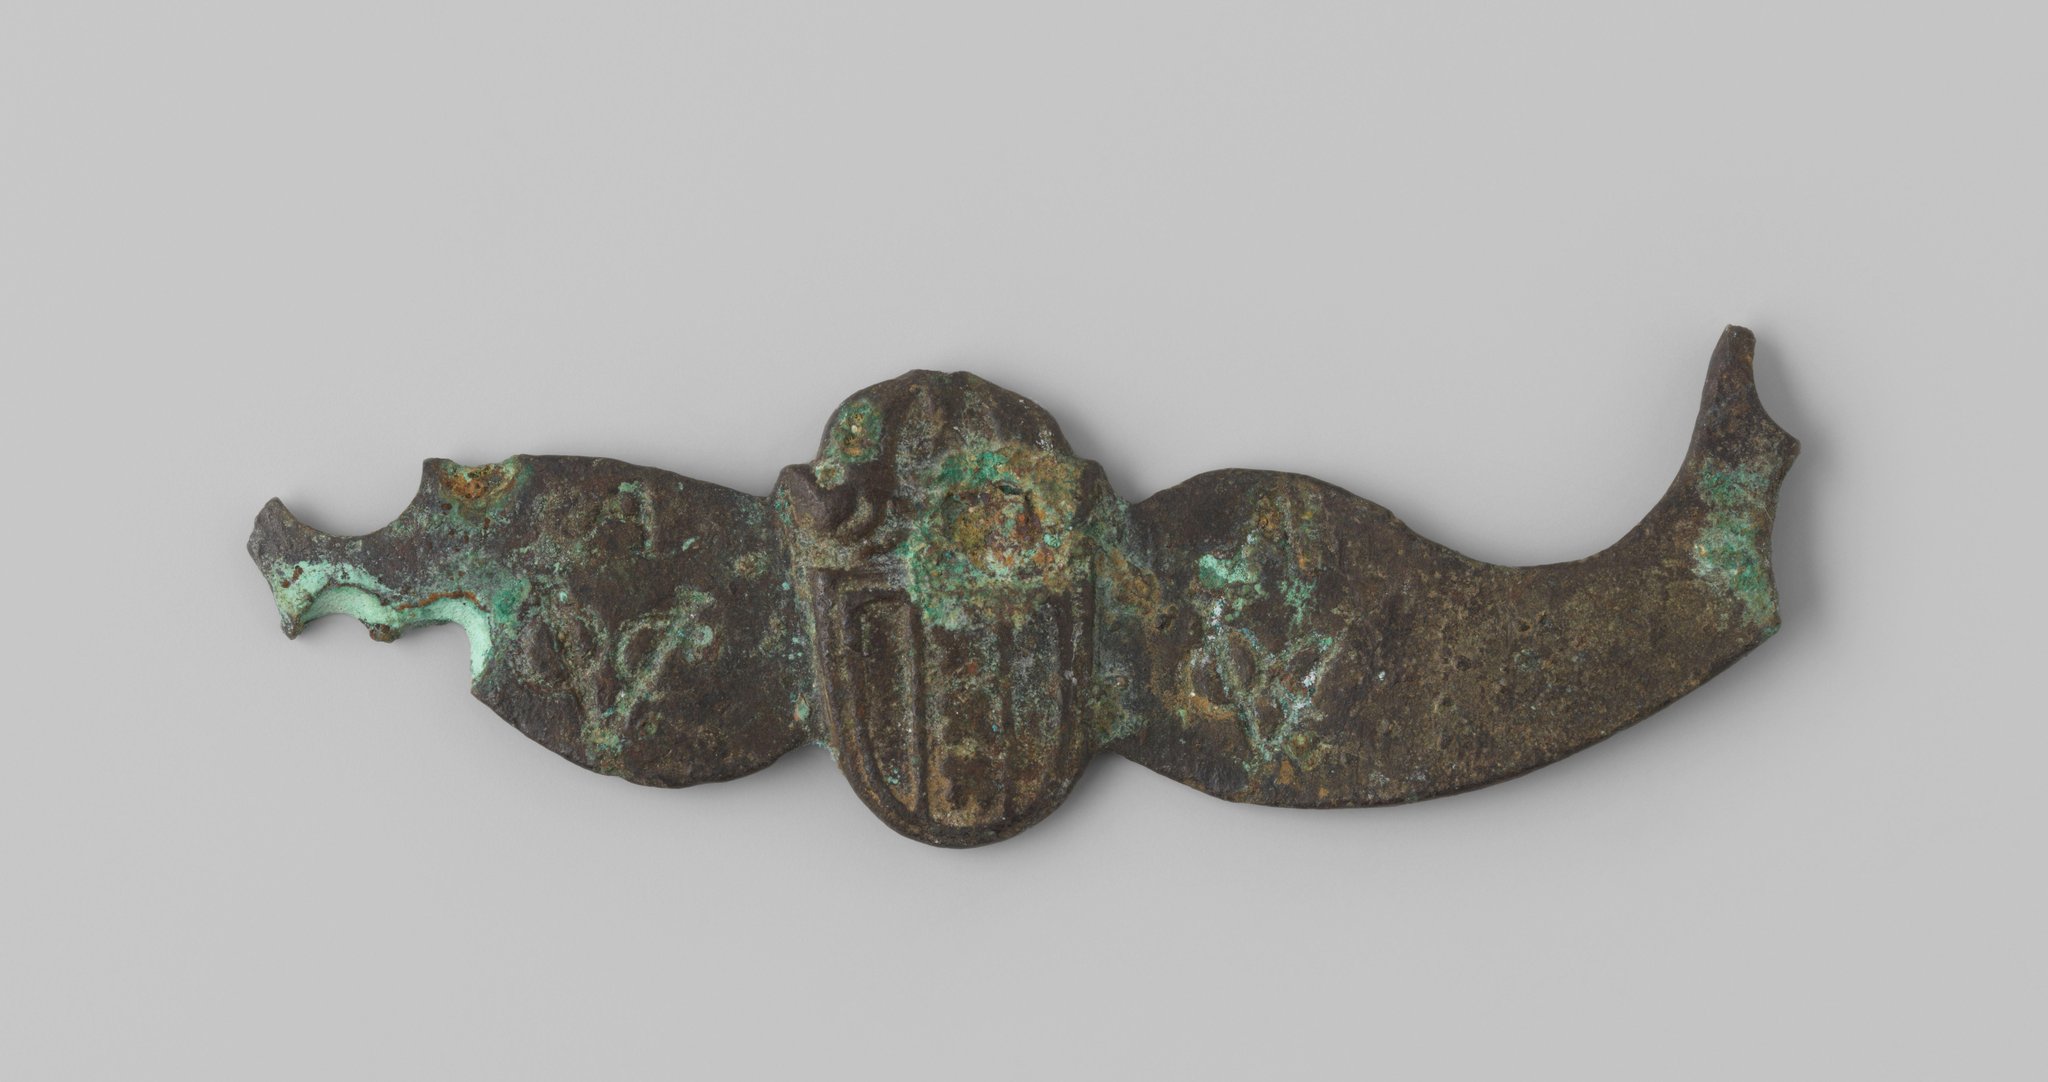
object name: musket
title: Musket uit het wrak van de Oost-Indiëvaarder Hollandia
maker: Anonymous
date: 1700-1743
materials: copper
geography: netherlands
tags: verenigde oostindische compagnie, hollandia (schip), annet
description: Fragm, id. NG 1978-74H986 or NG 1980-27H3069, eyes broken off, side plate.